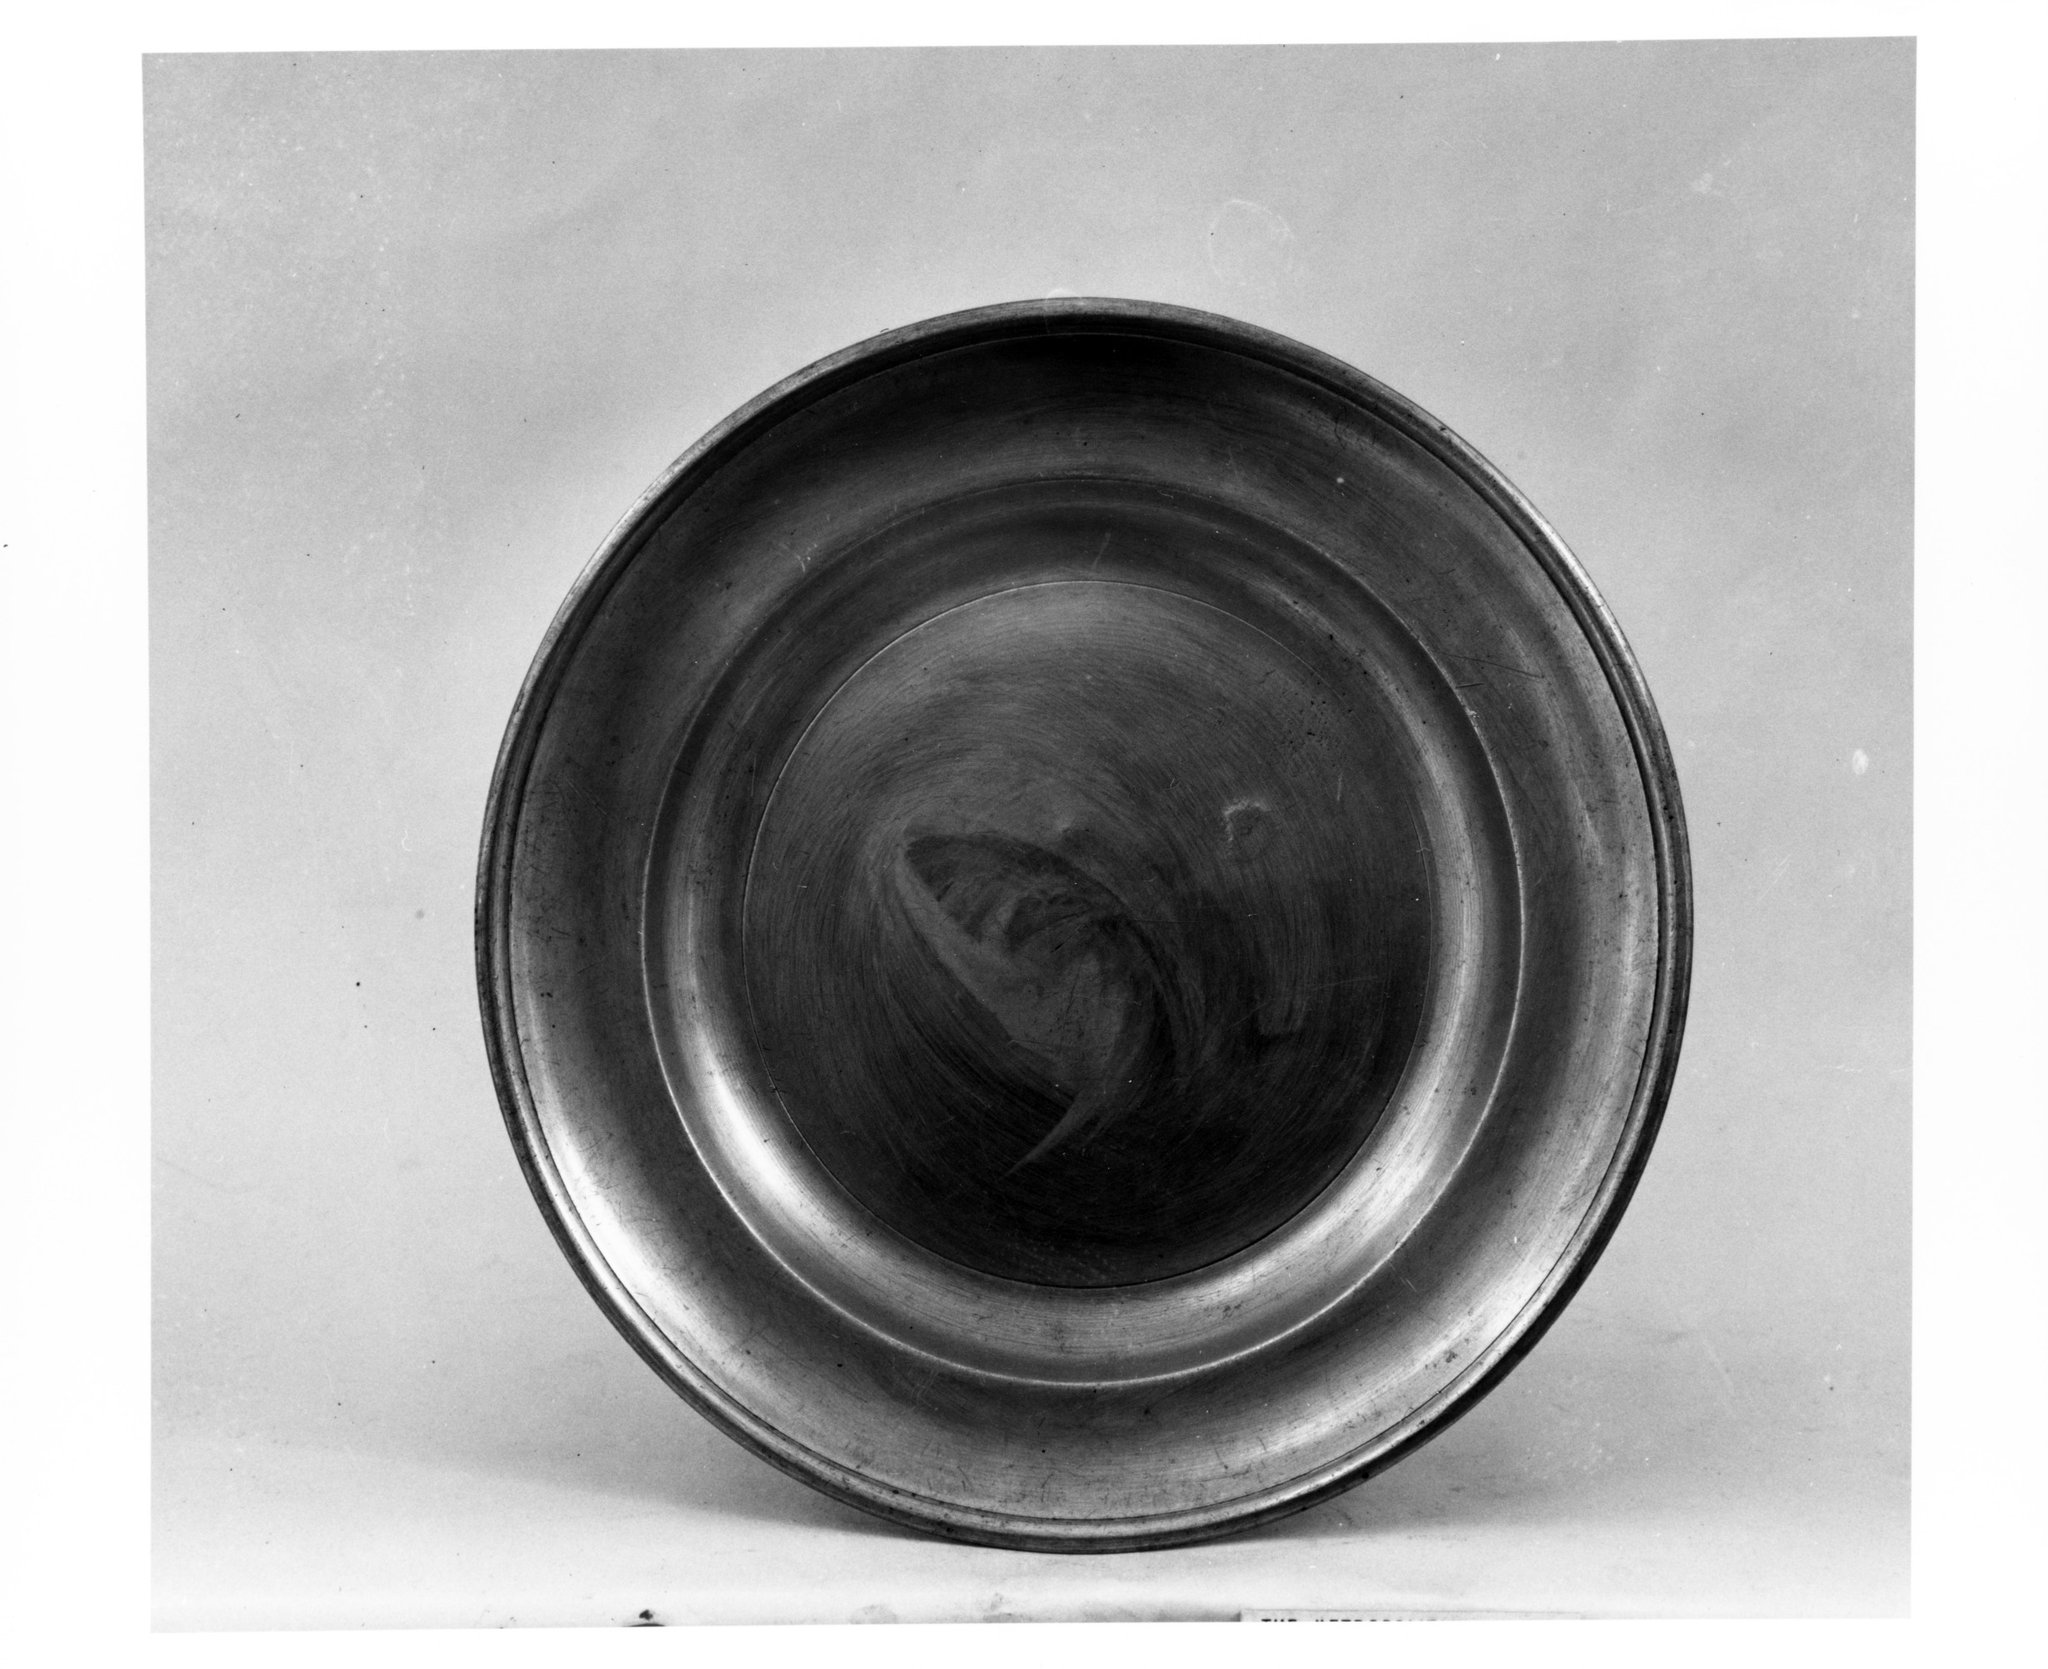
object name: plate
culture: american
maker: joseph danforth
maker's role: maker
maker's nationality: american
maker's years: 1758-1788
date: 1780-1788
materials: pewter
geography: united states